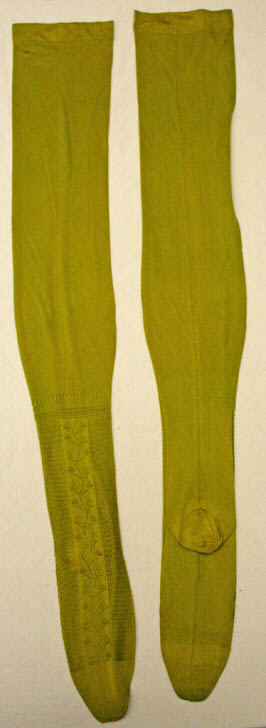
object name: stocking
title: Stockings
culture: french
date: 1801-1900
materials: silk